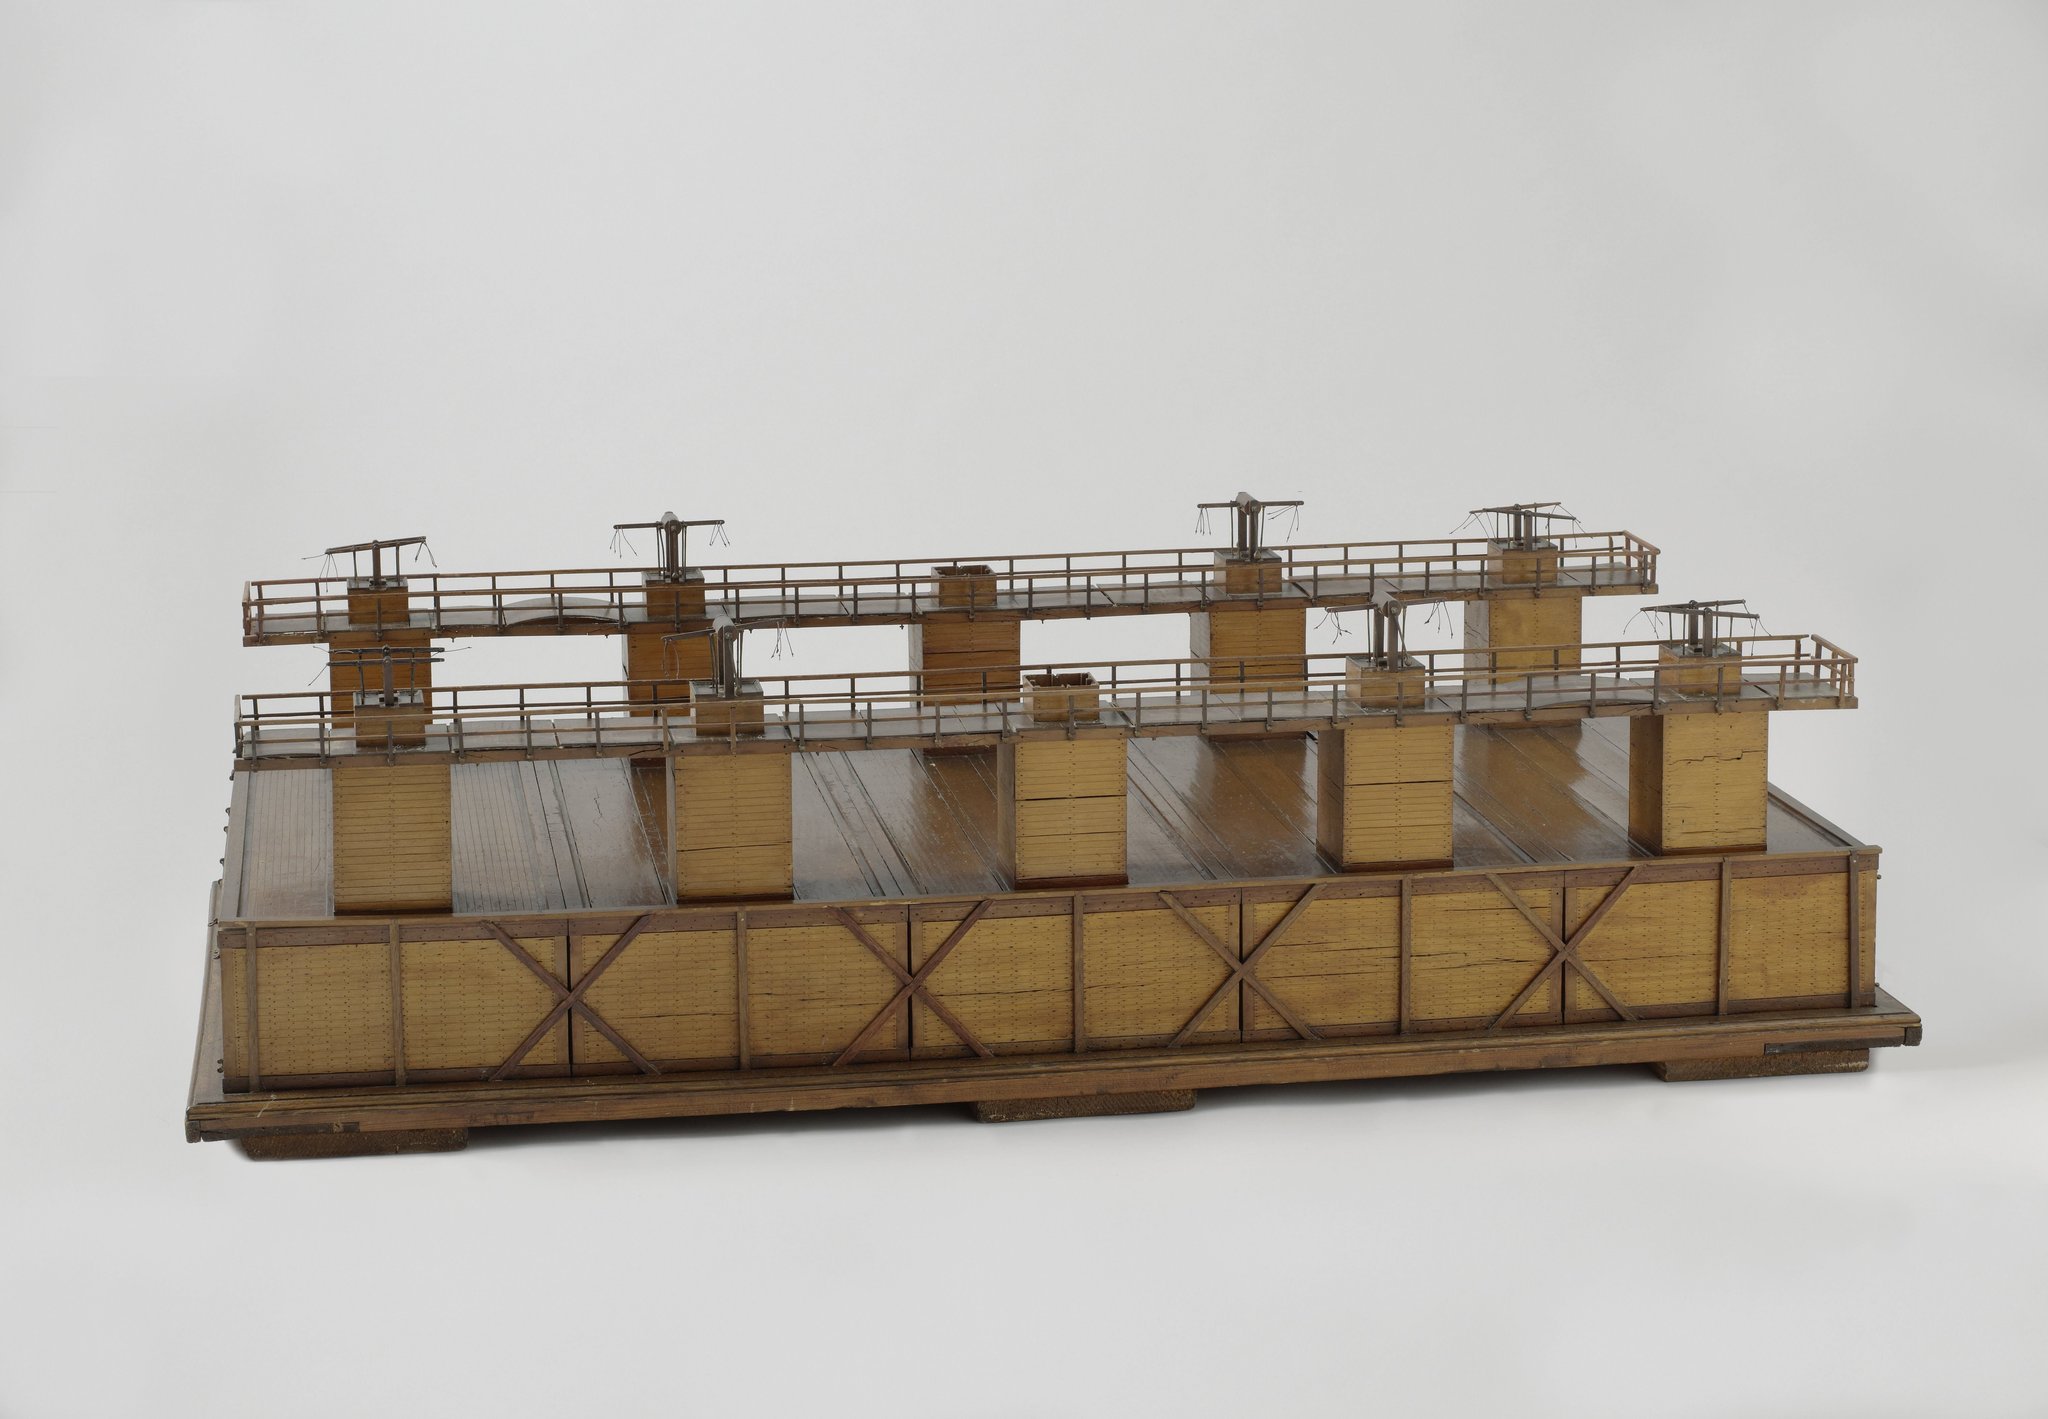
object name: demonstration model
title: Model of a Floating Dry Dock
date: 1802-1815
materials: brass, fiber, wood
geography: amsterdam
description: Model van een drijvend droogdok, op een grondplank. Het bestaat uit vijf delen, die aan elkaar verbonden zijn. Elk deel is een rechthoekige bak of ponton met op ieder eind een toren. Bovenop iedere toren zijn vier pompen aangebracht, die de ponton leeg moeten pompen. De vijf delen zijn aan elkaar verbonden door latwerk aan de buitenzijde en loopgangen met reling die de torens verbinden. Het model laat twee typen pompen zien: dubbele slagpompen en pompen waarvan de pompstangen aan een trommel verbonden zijn, die met hefbomen heen en weer bewogen wordt. Buitenop zijn aan de as van deze trommels aan weerszijden slingers met een gewicht bevestigd.